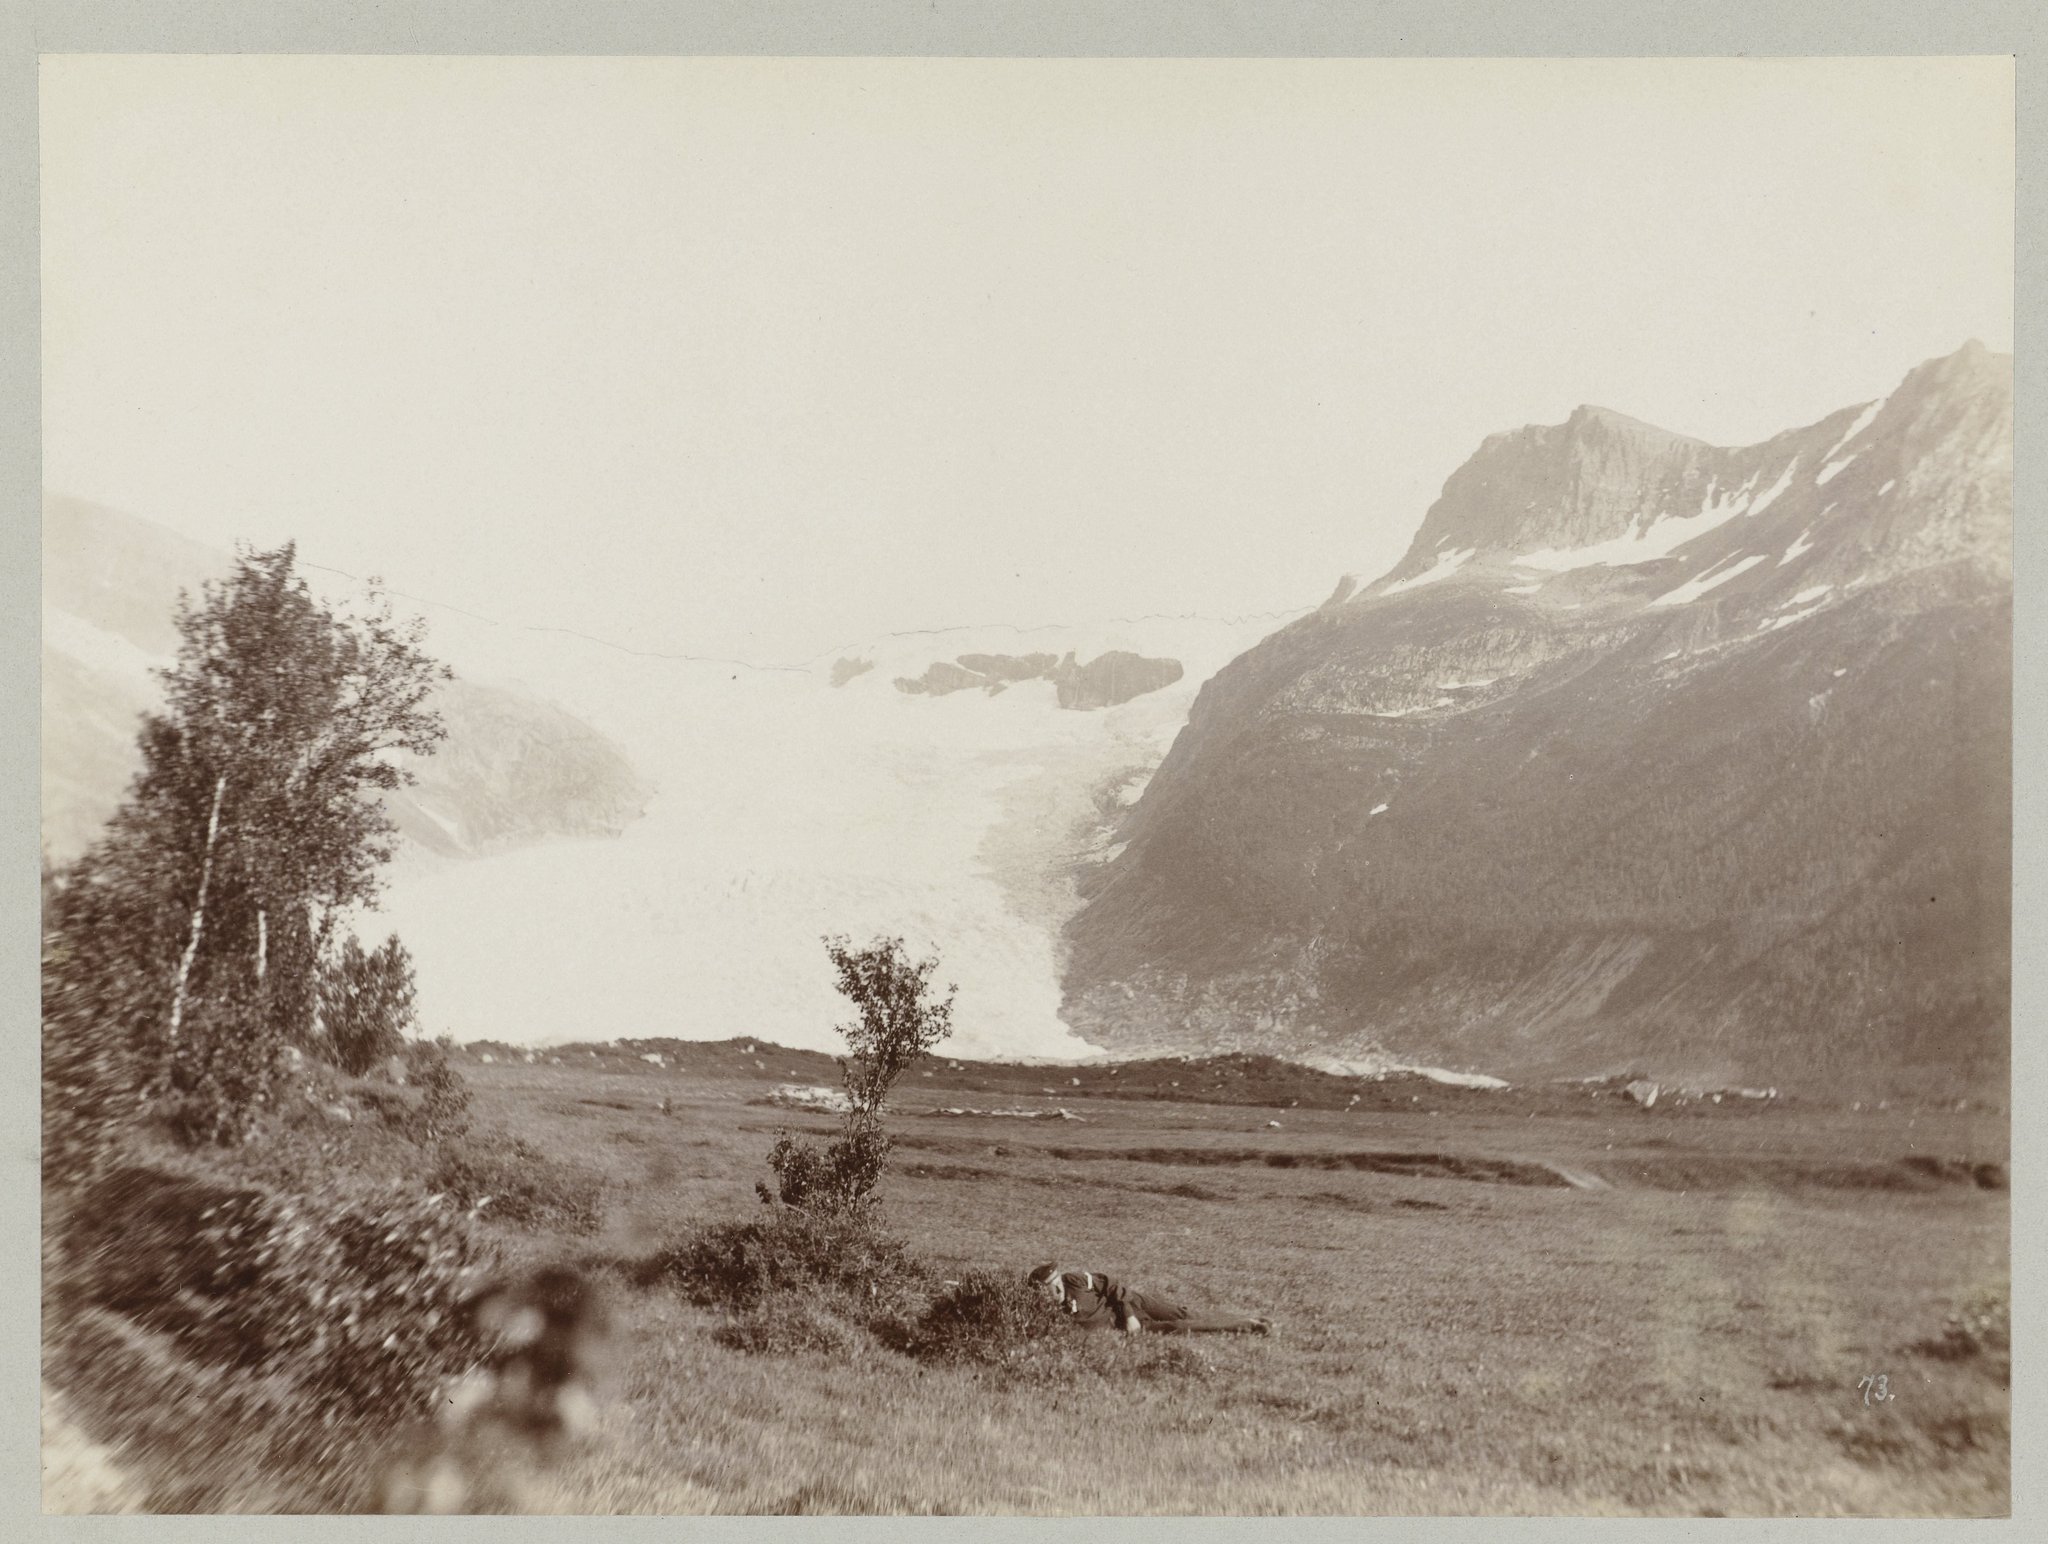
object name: photograph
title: De Noorse gletsjer Svartisen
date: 1807-1889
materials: cardboard, paper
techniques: albumen print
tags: wilhelm ii (keizer van duitsland), norway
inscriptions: number: ‘35’, number: ‘73’